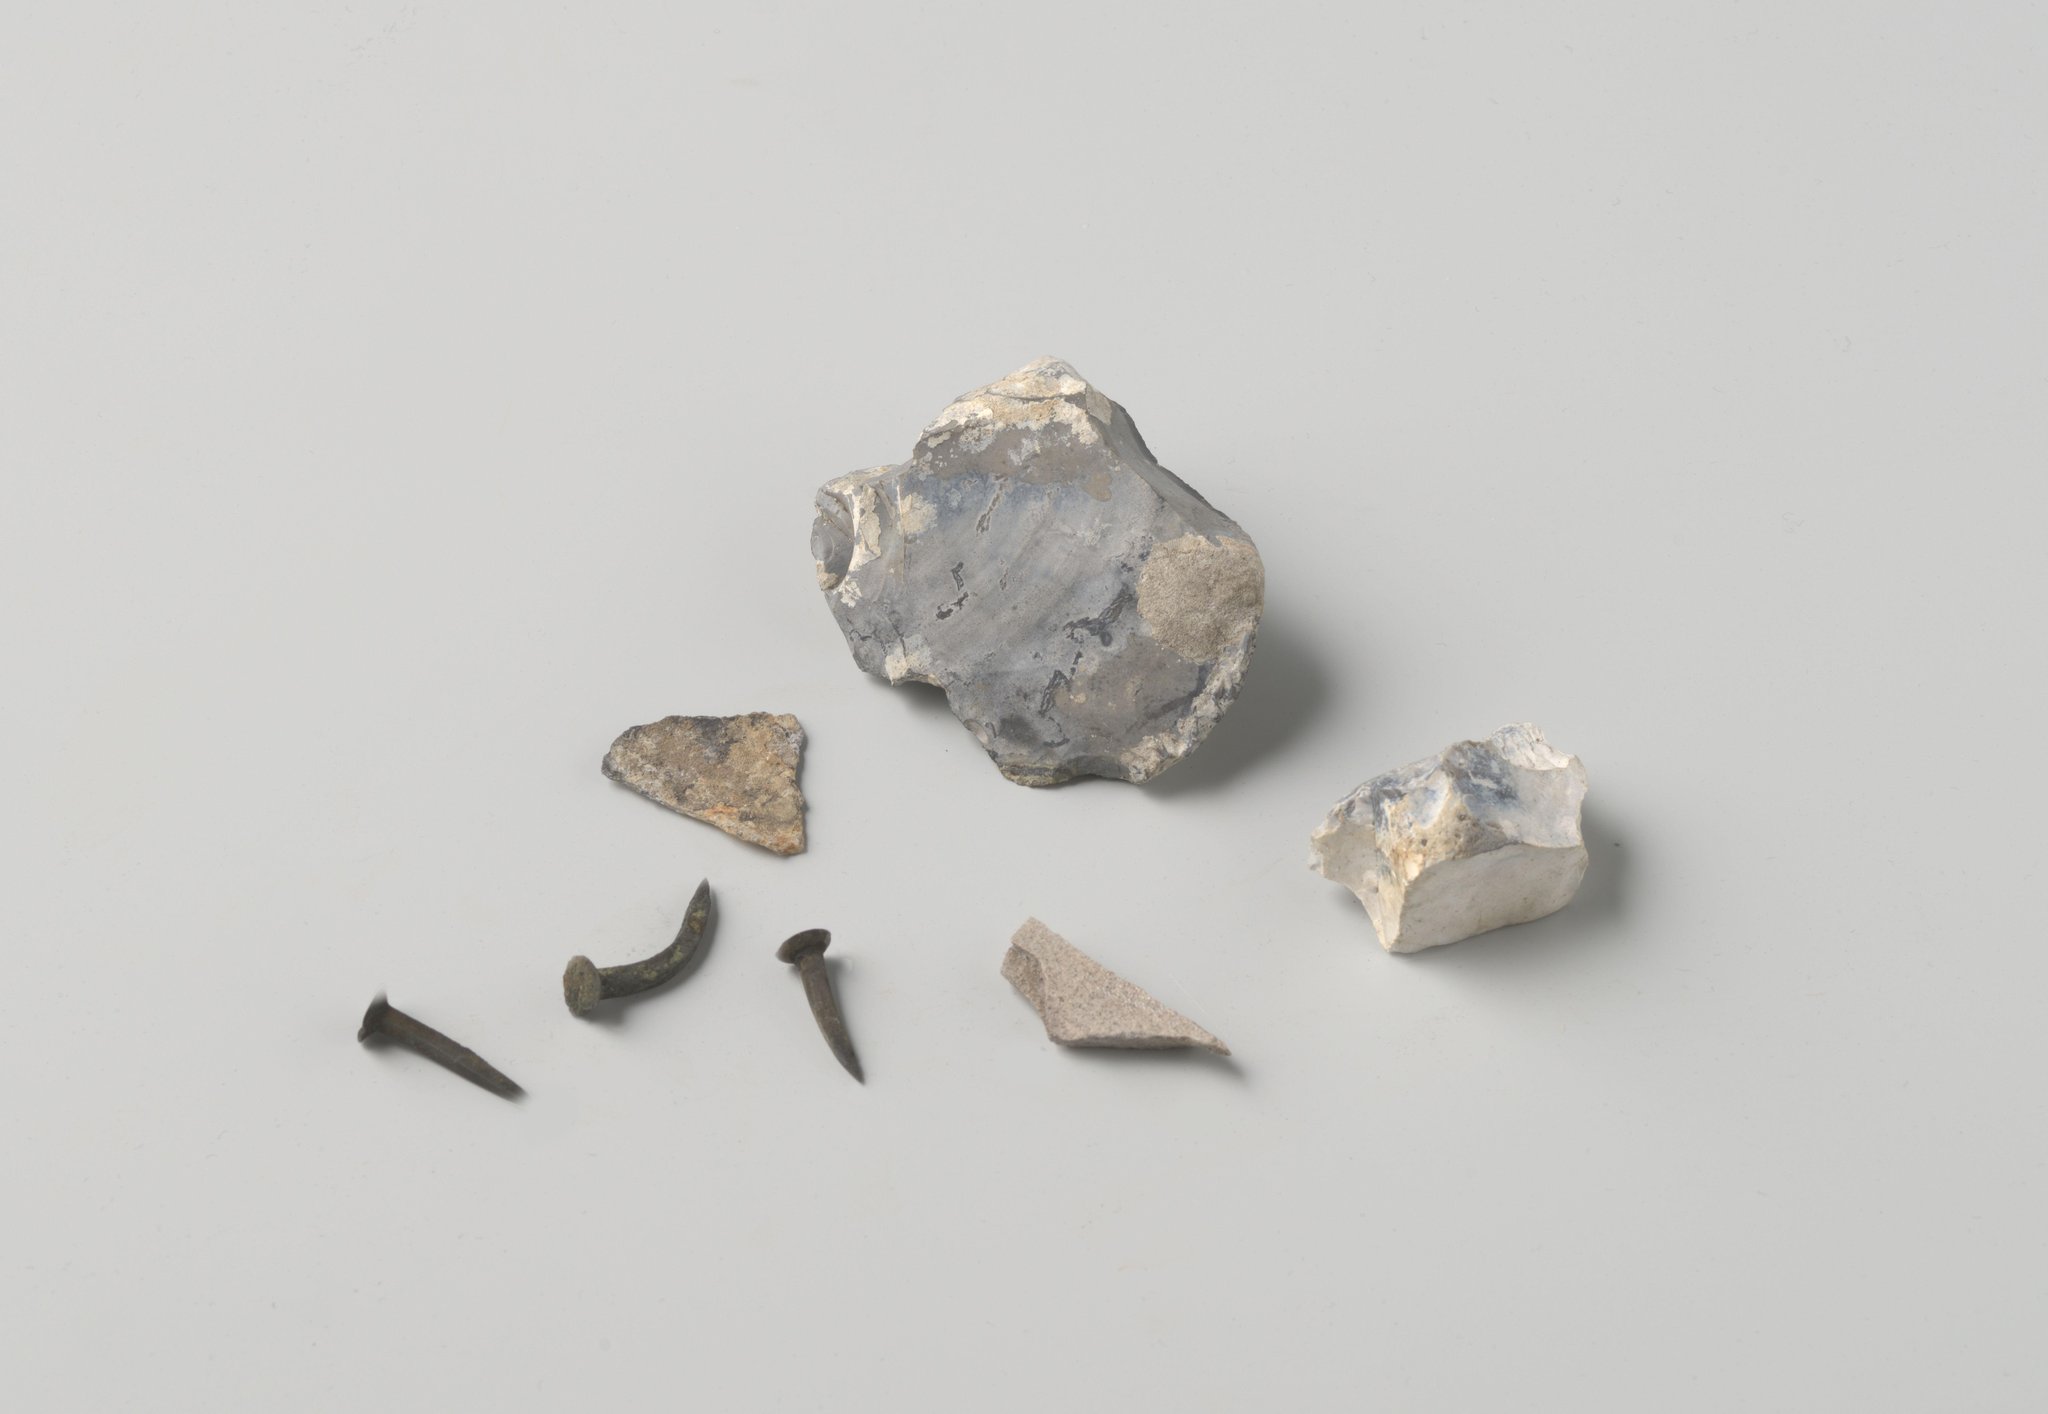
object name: nagel, spijker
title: Spijkers, vuursteen, steengoedscherf en tin- of loodfragment uit het wrak van de Oostindiëvaarder Hollandia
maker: Anonymous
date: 1700-1743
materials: stone, iron, lead, stoneware, tin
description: Drie spijkers, twee brokken vuursteen, een steengoedscherf en een tin- of loodfragment.